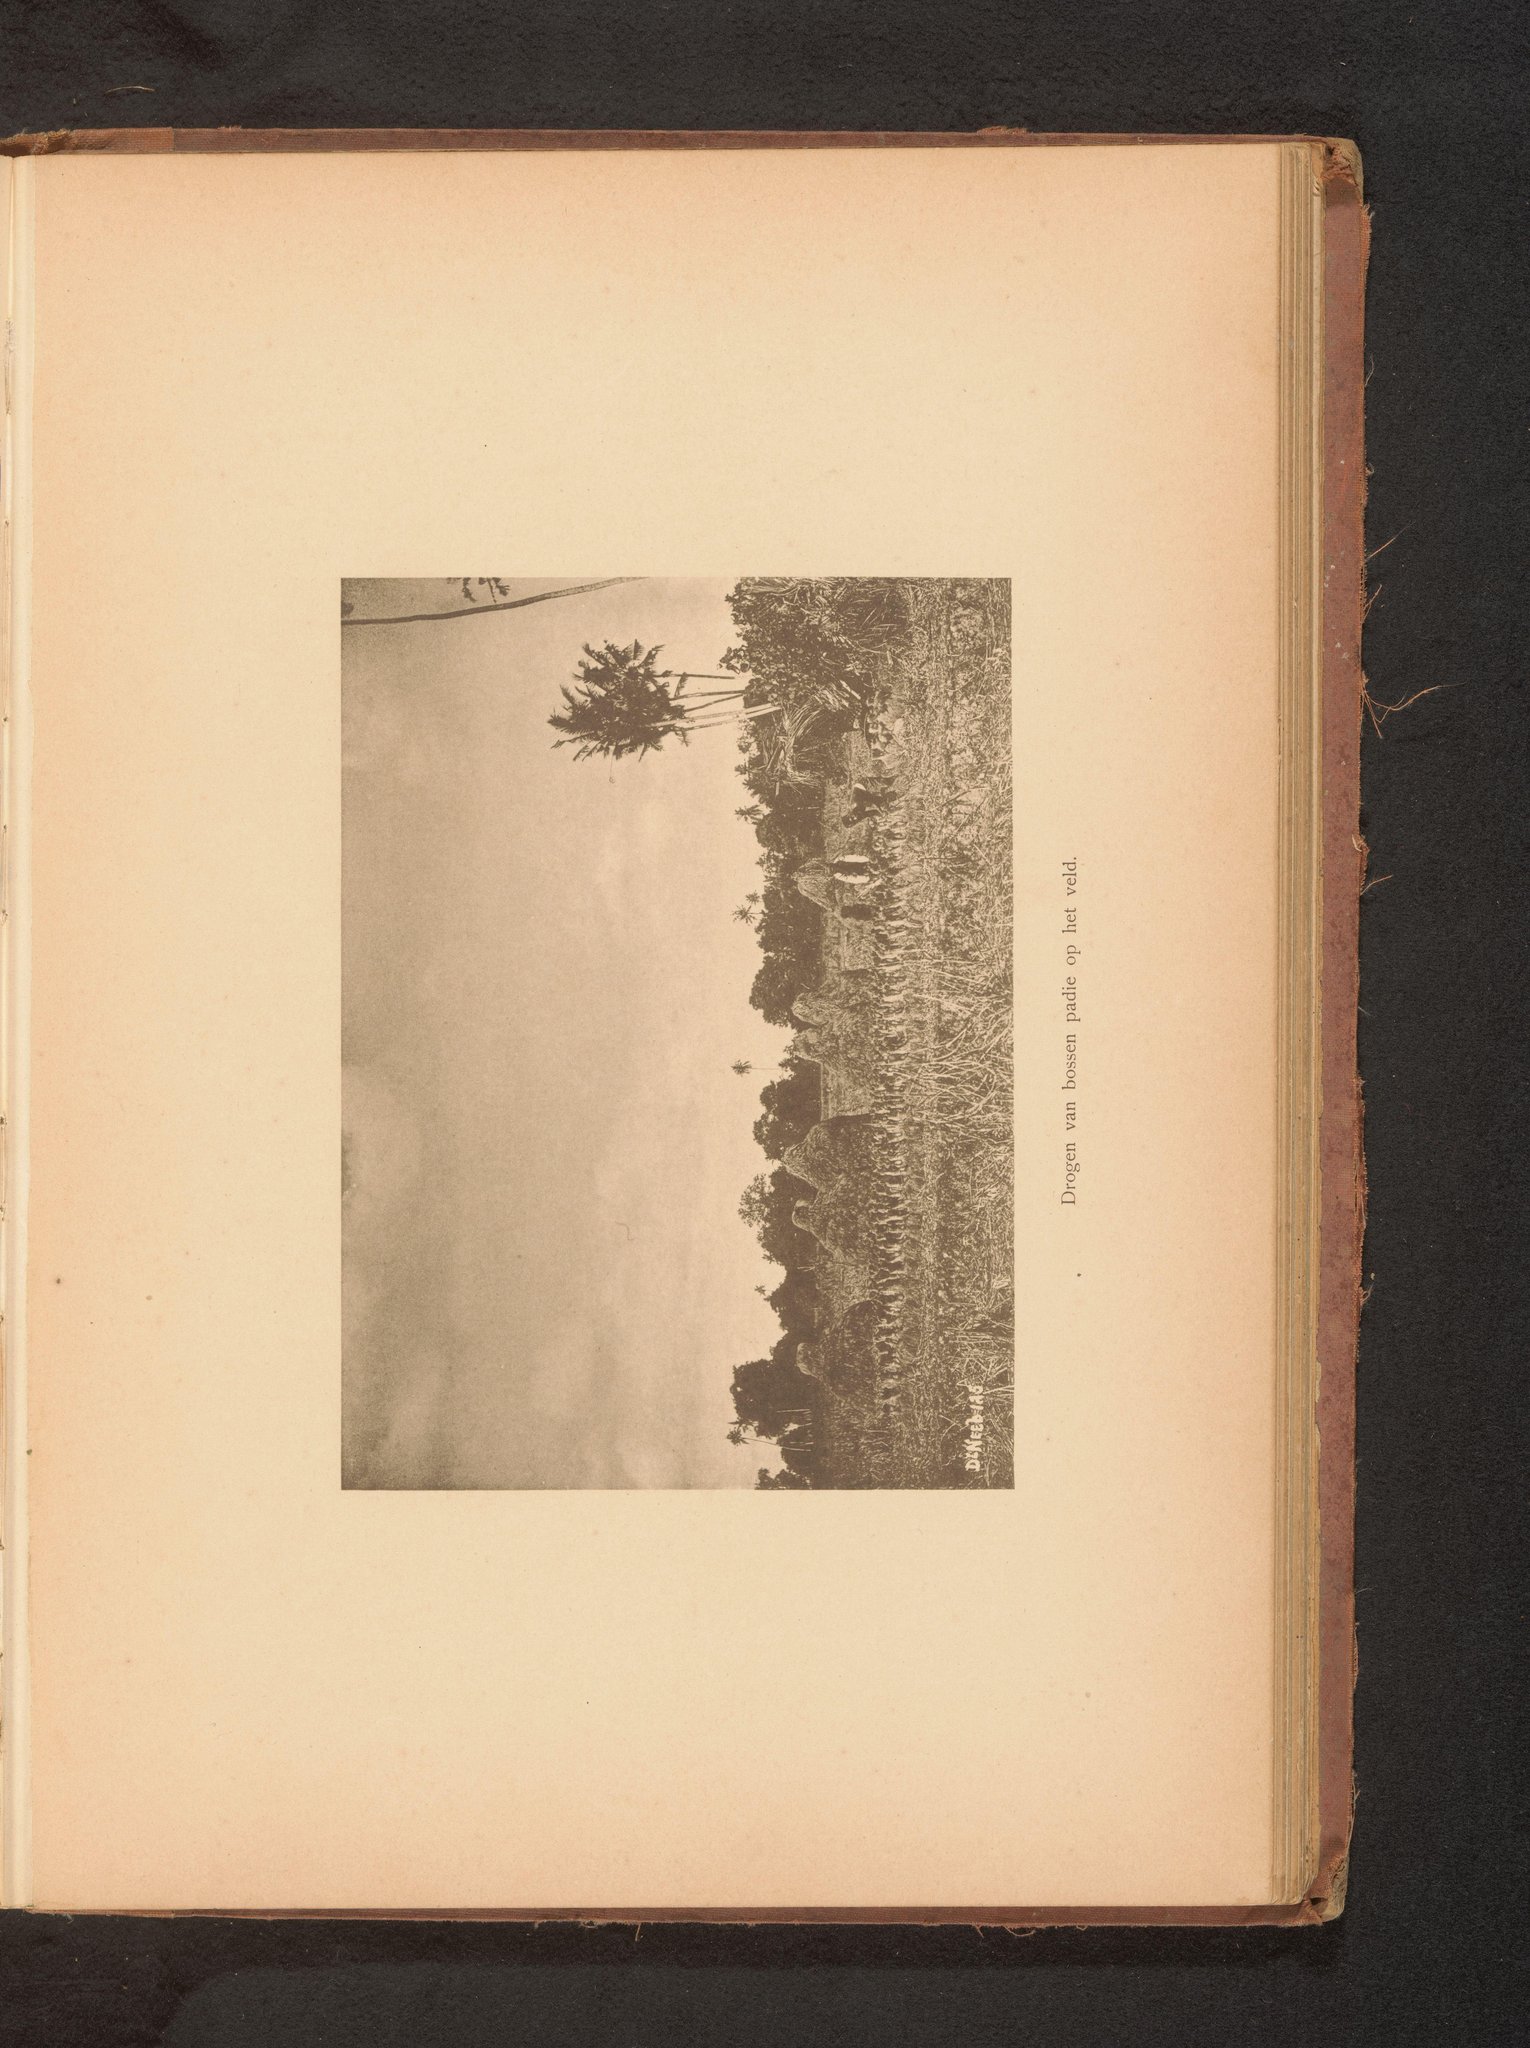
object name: page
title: Gezicht op een rijstveld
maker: christiaan johan neeb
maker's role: arts, fotograaf, officier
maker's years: 1860-1925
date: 1892-1897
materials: paper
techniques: photograph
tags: sawahs, rice paddies, indonesia